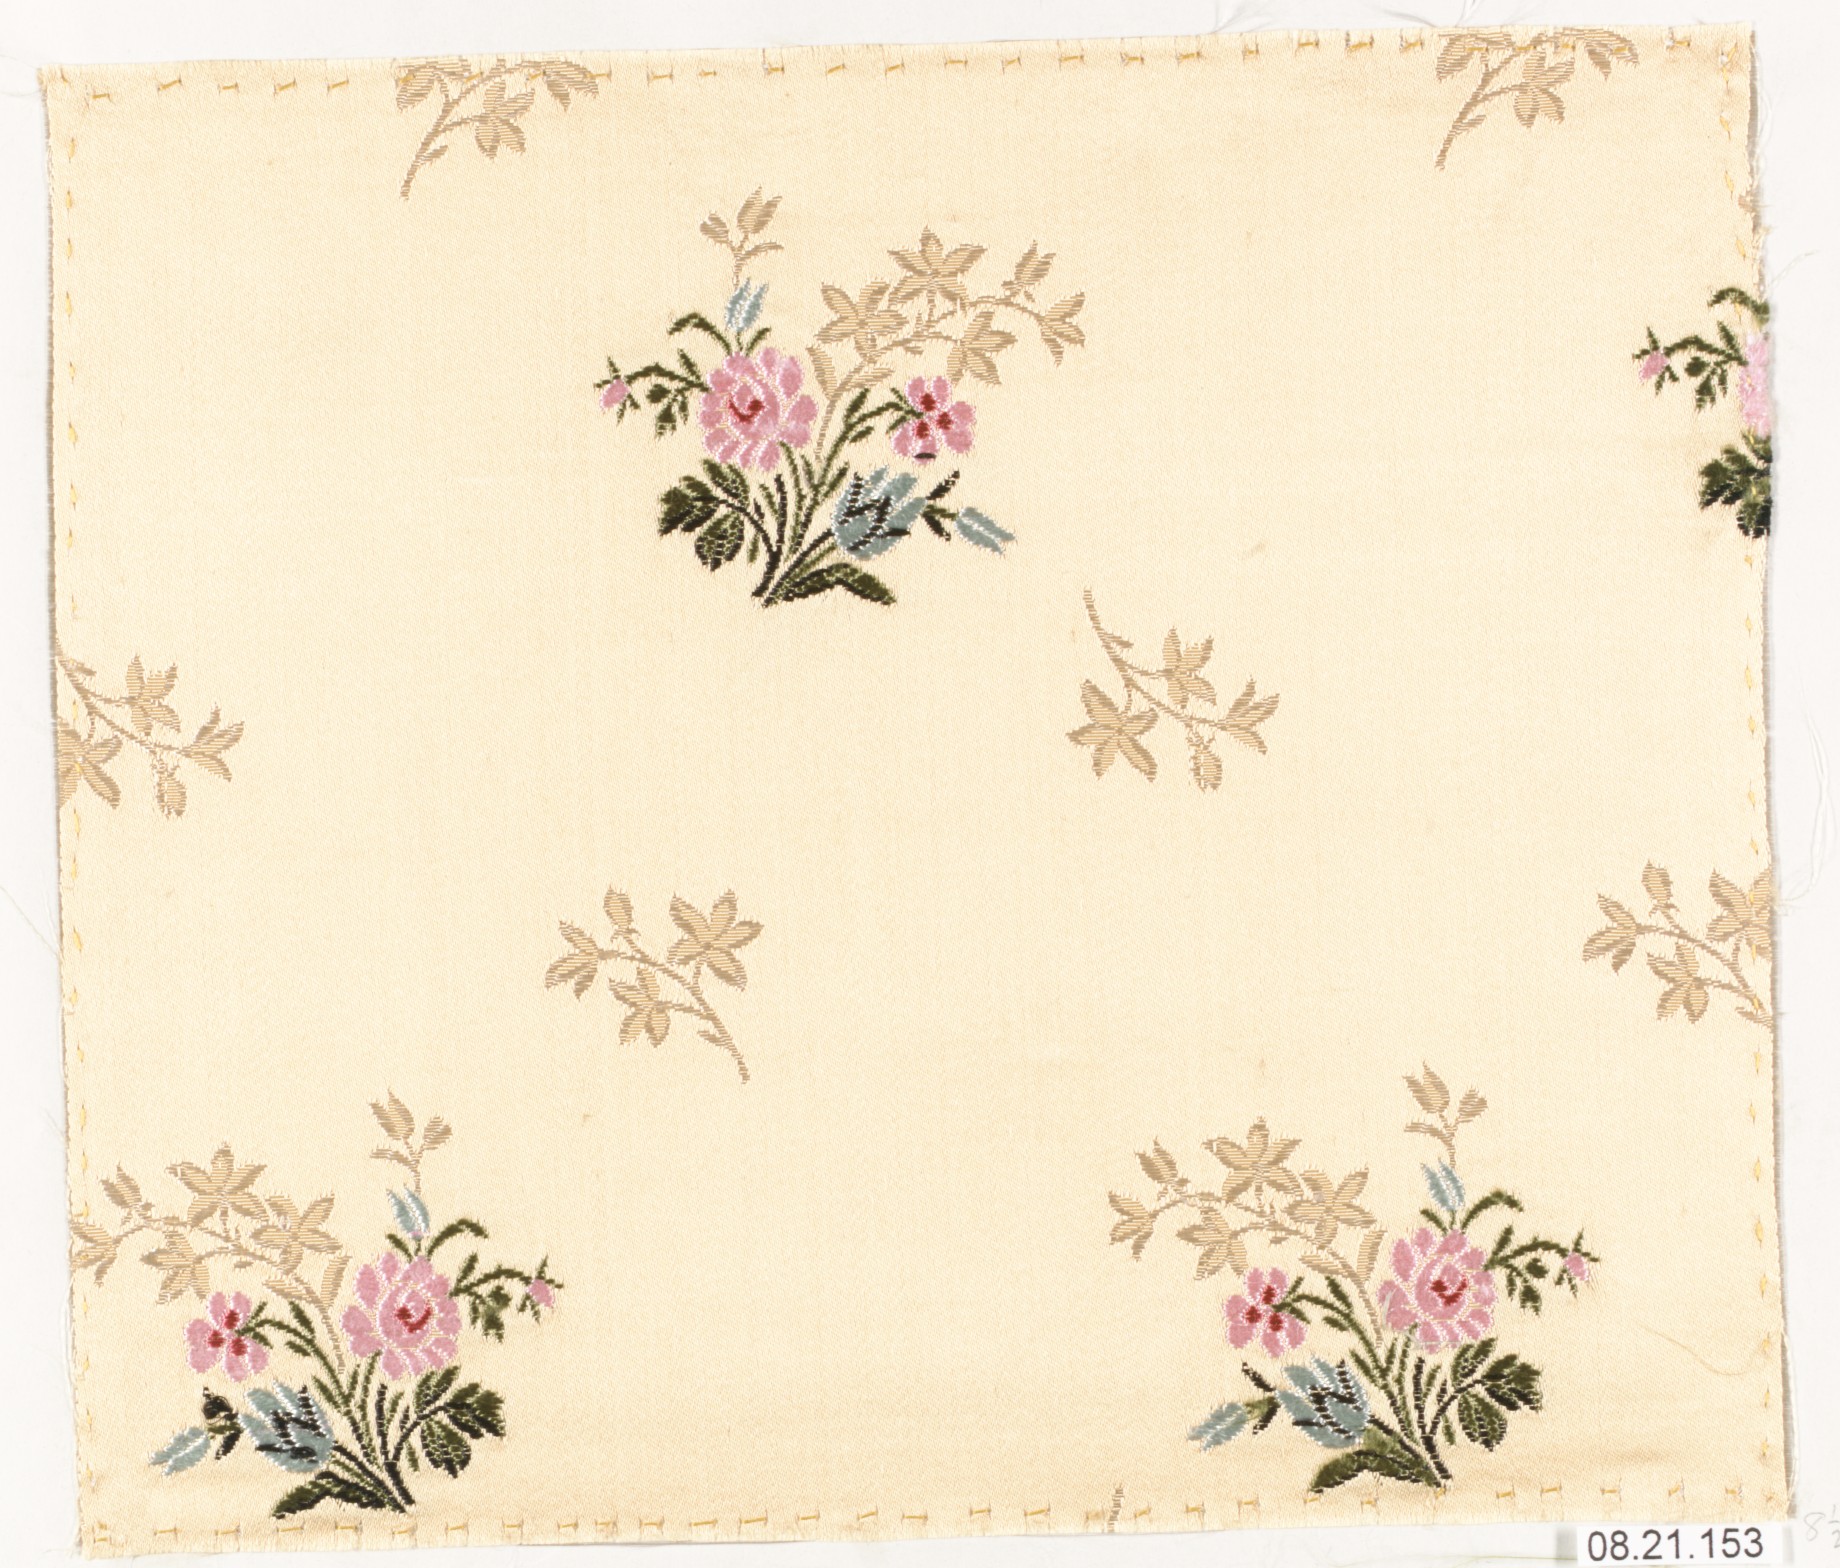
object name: textile sample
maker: Anonymous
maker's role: designer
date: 1900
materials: silk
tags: flowers